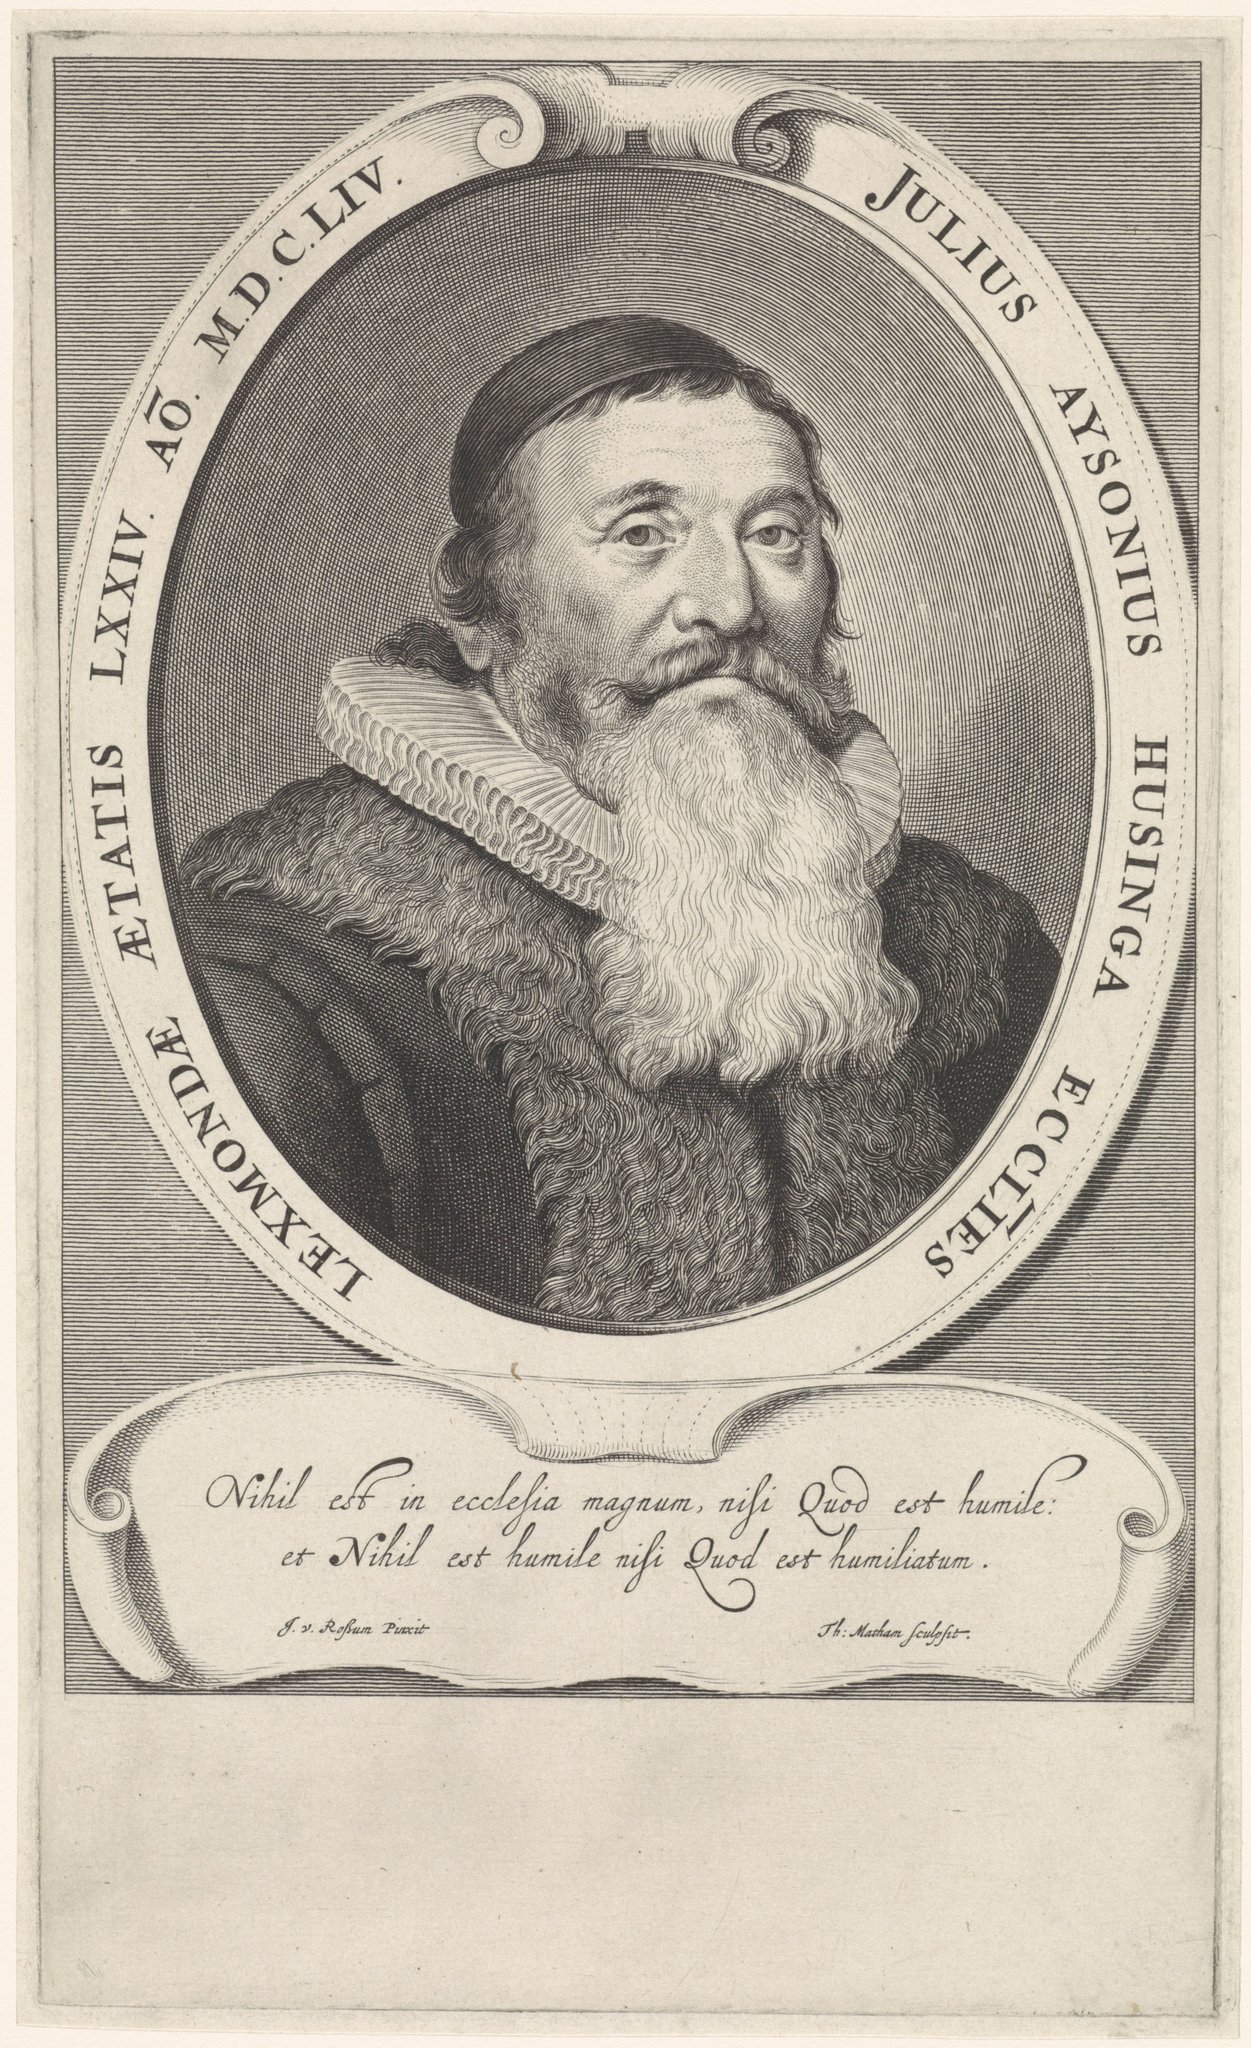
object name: print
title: Portret van Julius Ayssonius Husinga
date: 1654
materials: paper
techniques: engraving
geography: northern netherlands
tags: julius ayssonius husinga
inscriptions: collector's mark: Lugt 240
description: Portret van Julius Ayssonius Husinga, predikant te Lexmond, op 74-jarige leeftijd.